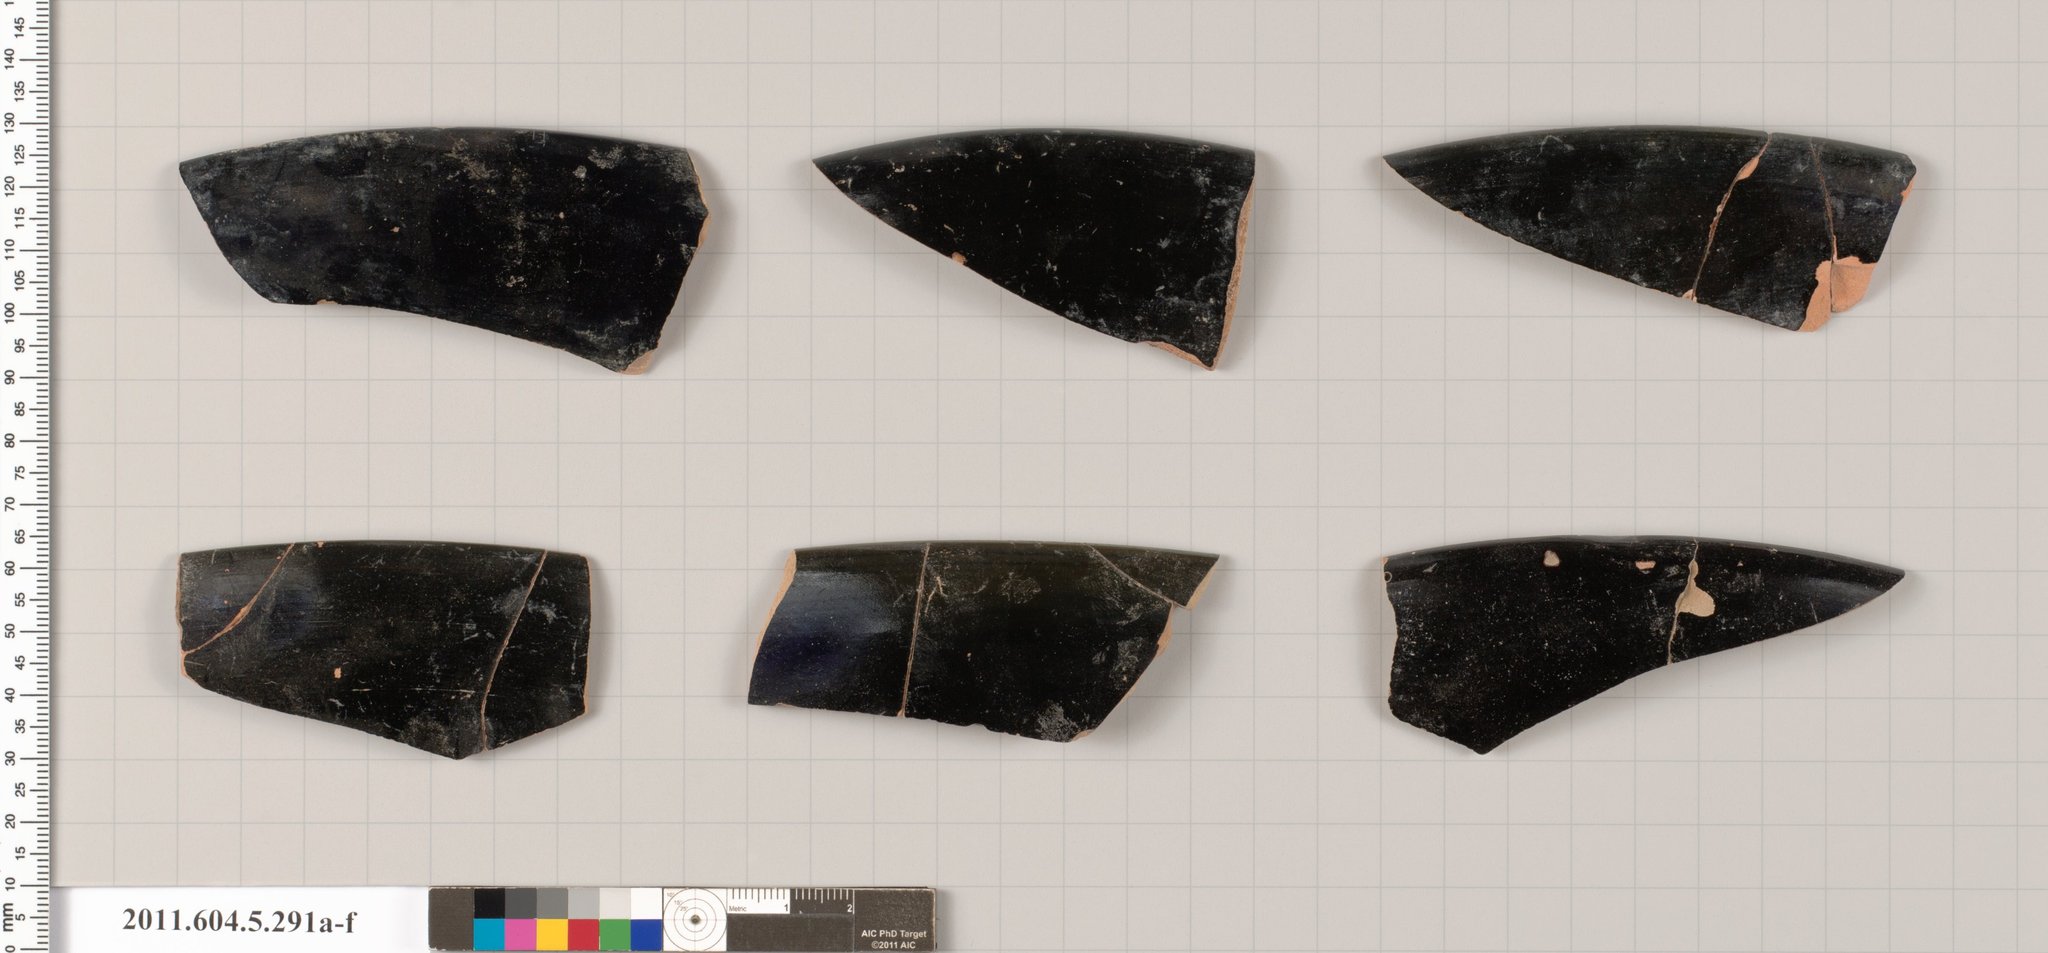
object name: kylix fragment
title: Terracotta rim fragments of kylikes (drinking cups)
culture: greek, attic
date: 600-401 BCE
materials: terracotta